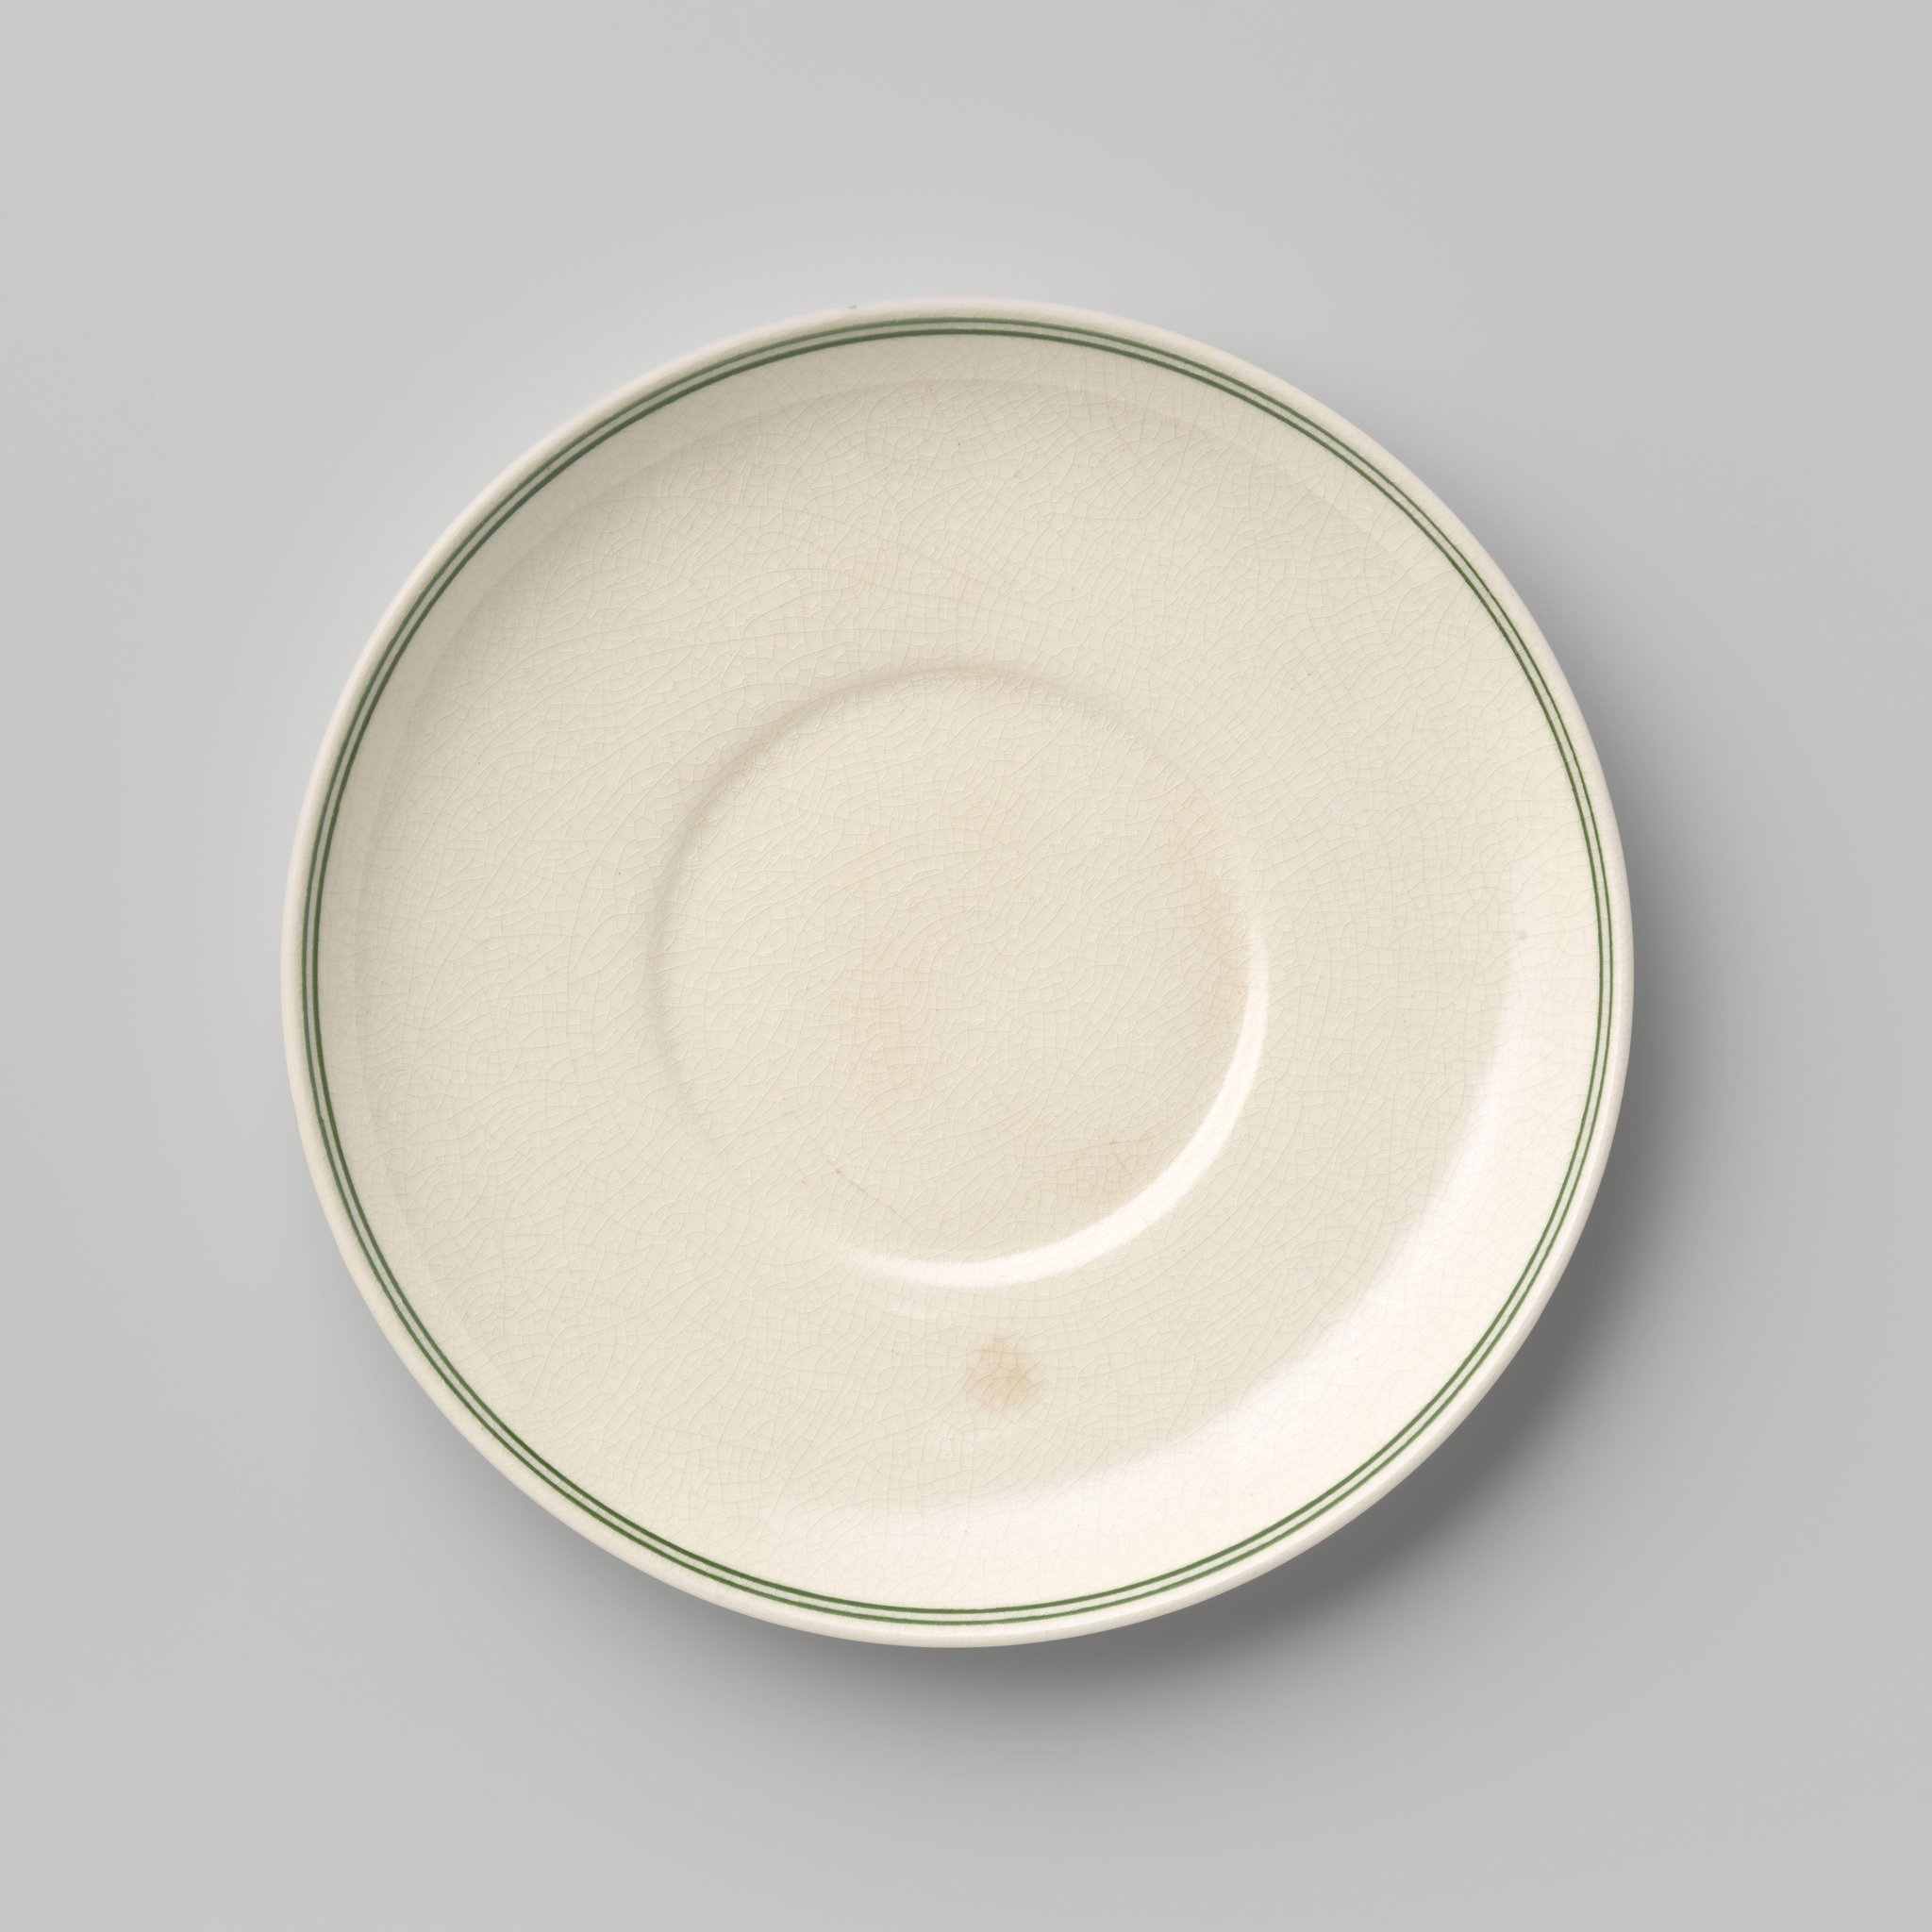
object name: service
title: Schotel van een soepkop, van aardewerk en versierd met blokpatroon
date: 1900-1925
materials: earthenware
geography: gouda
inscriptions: mark: ‘fabrieksmerk (in zwart)’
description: Schotel van een soepkop, van aardewerk en versierd met een blokpatroon in groen en geel.